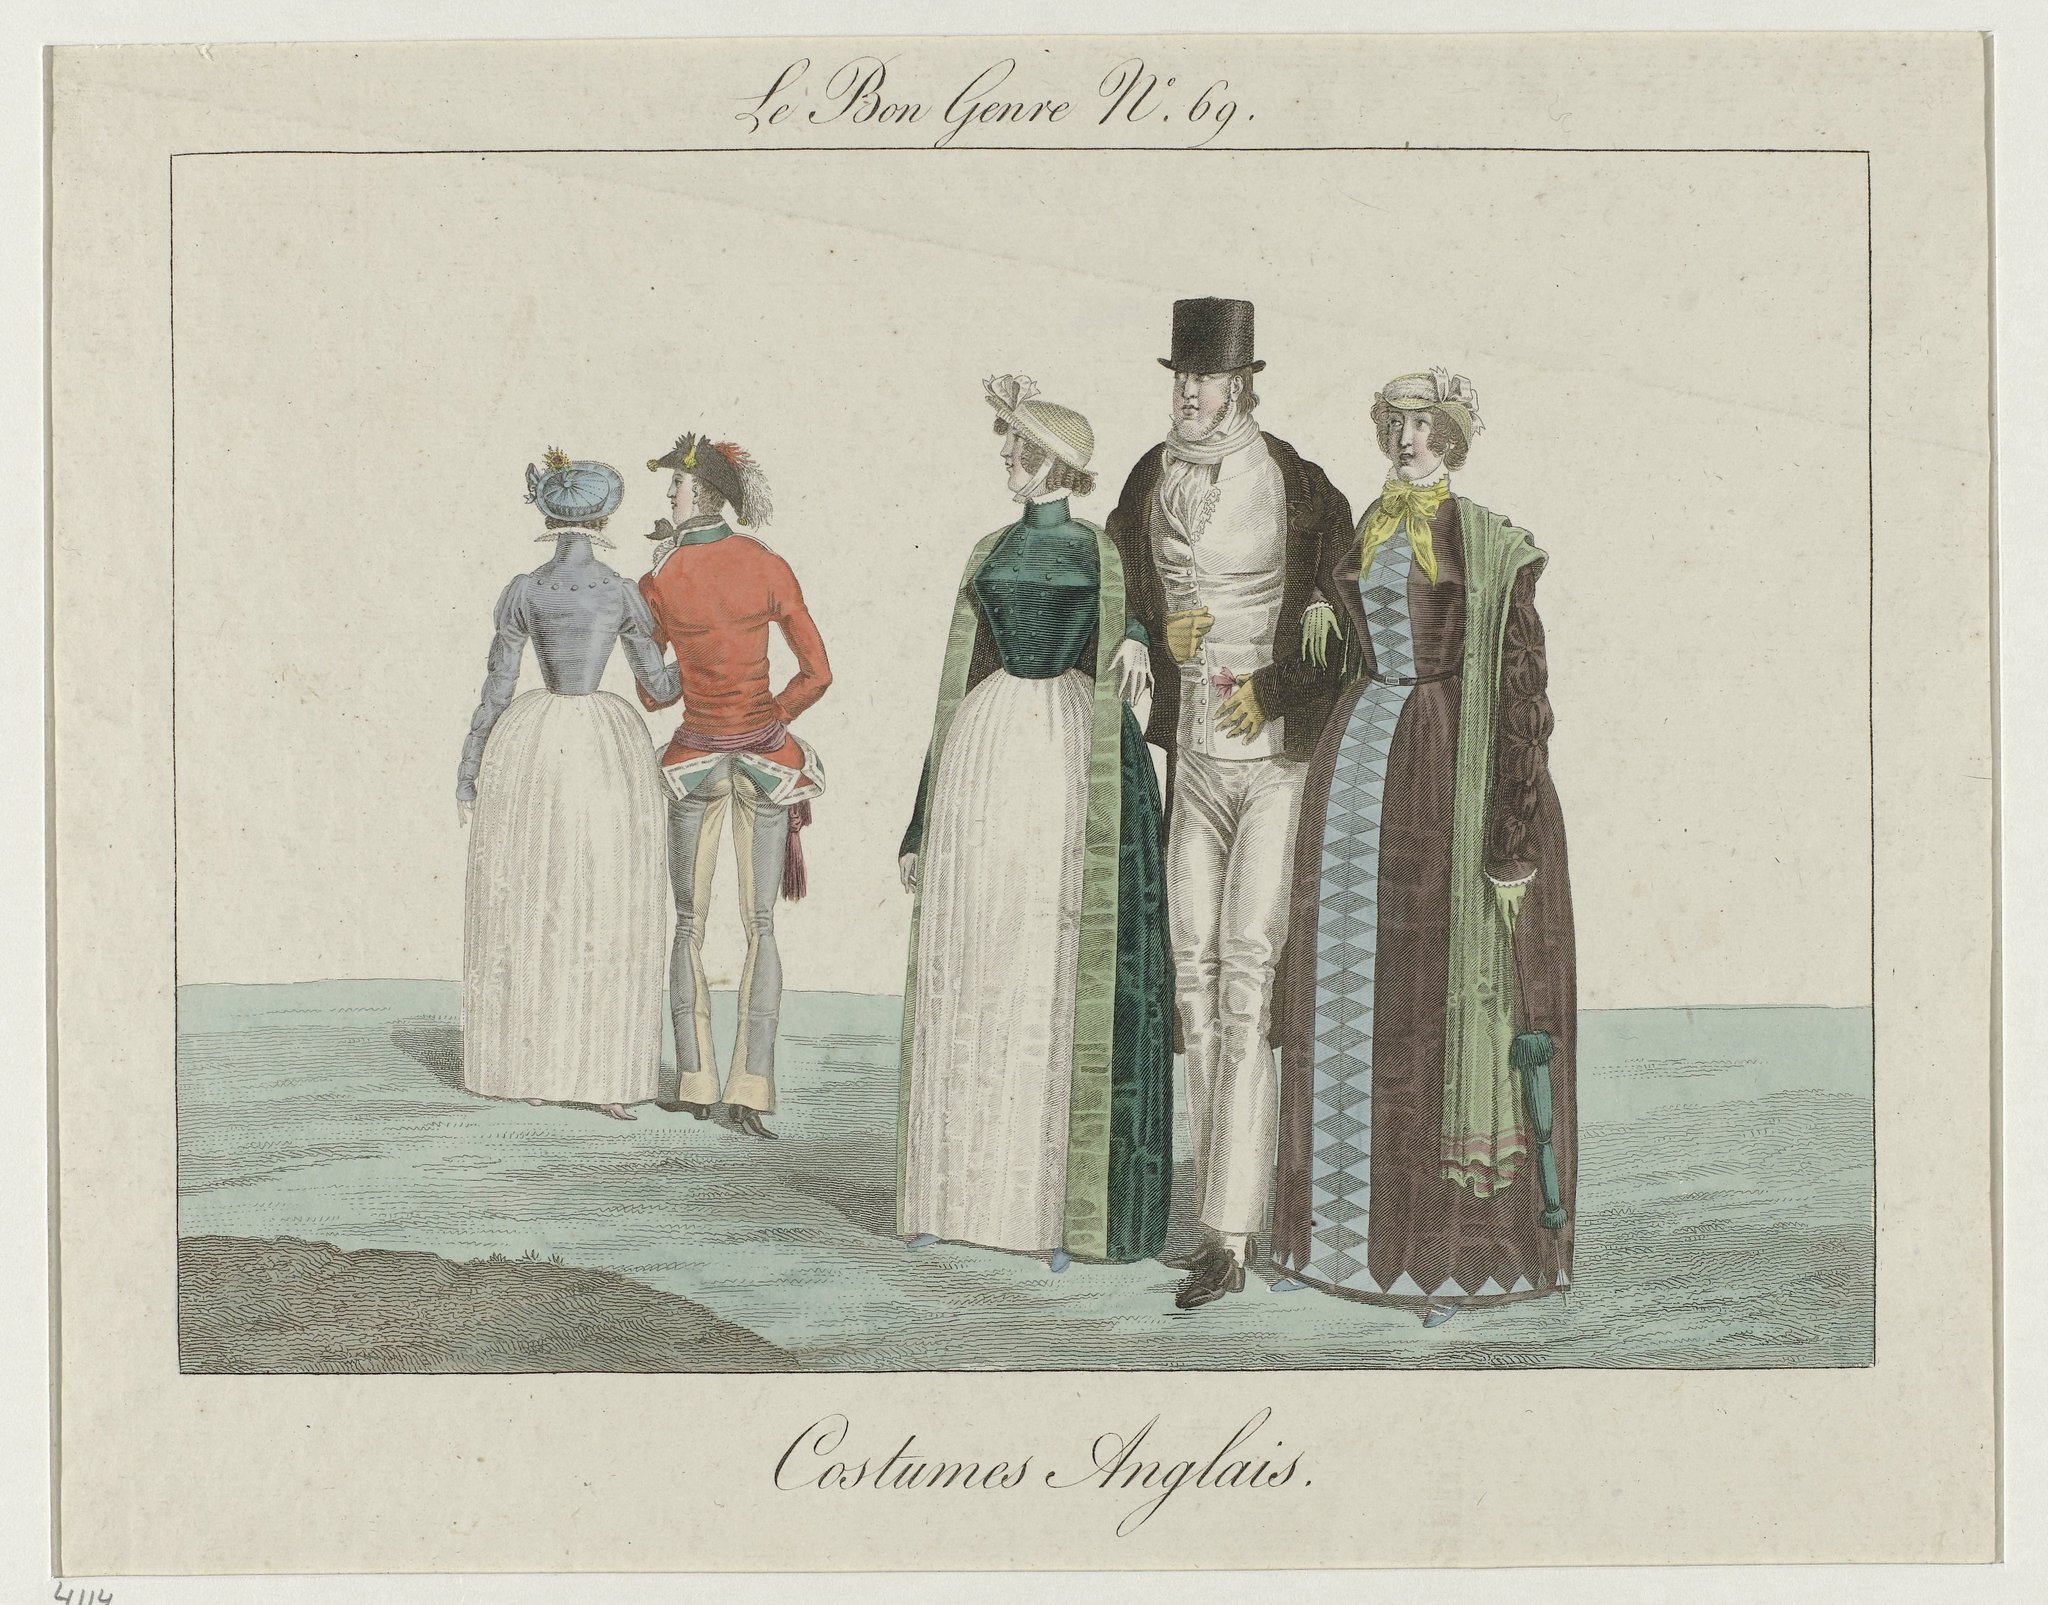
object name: fashion print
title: Le Bon Genre, 1817, No. 69 : Costumes Anglais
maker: Anonymous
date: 1817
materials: paper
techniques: engraving, hand coloring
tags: clothing for the upper part of the body (vest) (+ men's clothes), clothing for the upper part of the body (shawl) (+ women's clothes), trousers, breeches, etc. (pantalon) (+ men's clothes), trousers, breeches (+ men's clothes), coat (+ women's clothes), coat (frac) (+ men's clothes), fashion plates, head-gear: hat (+ women's clothes), skirt (+ women's clothes), dress, gown (+ women's clothes), (military) uniforms, neck-gear ~ clothing (+ women's clothes), head-gear: bicorne, bicorn (+ men's clothes)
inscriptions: caption: ‘Costumes Anglais.’, title: ‘Le Bon Genre No. 69.’